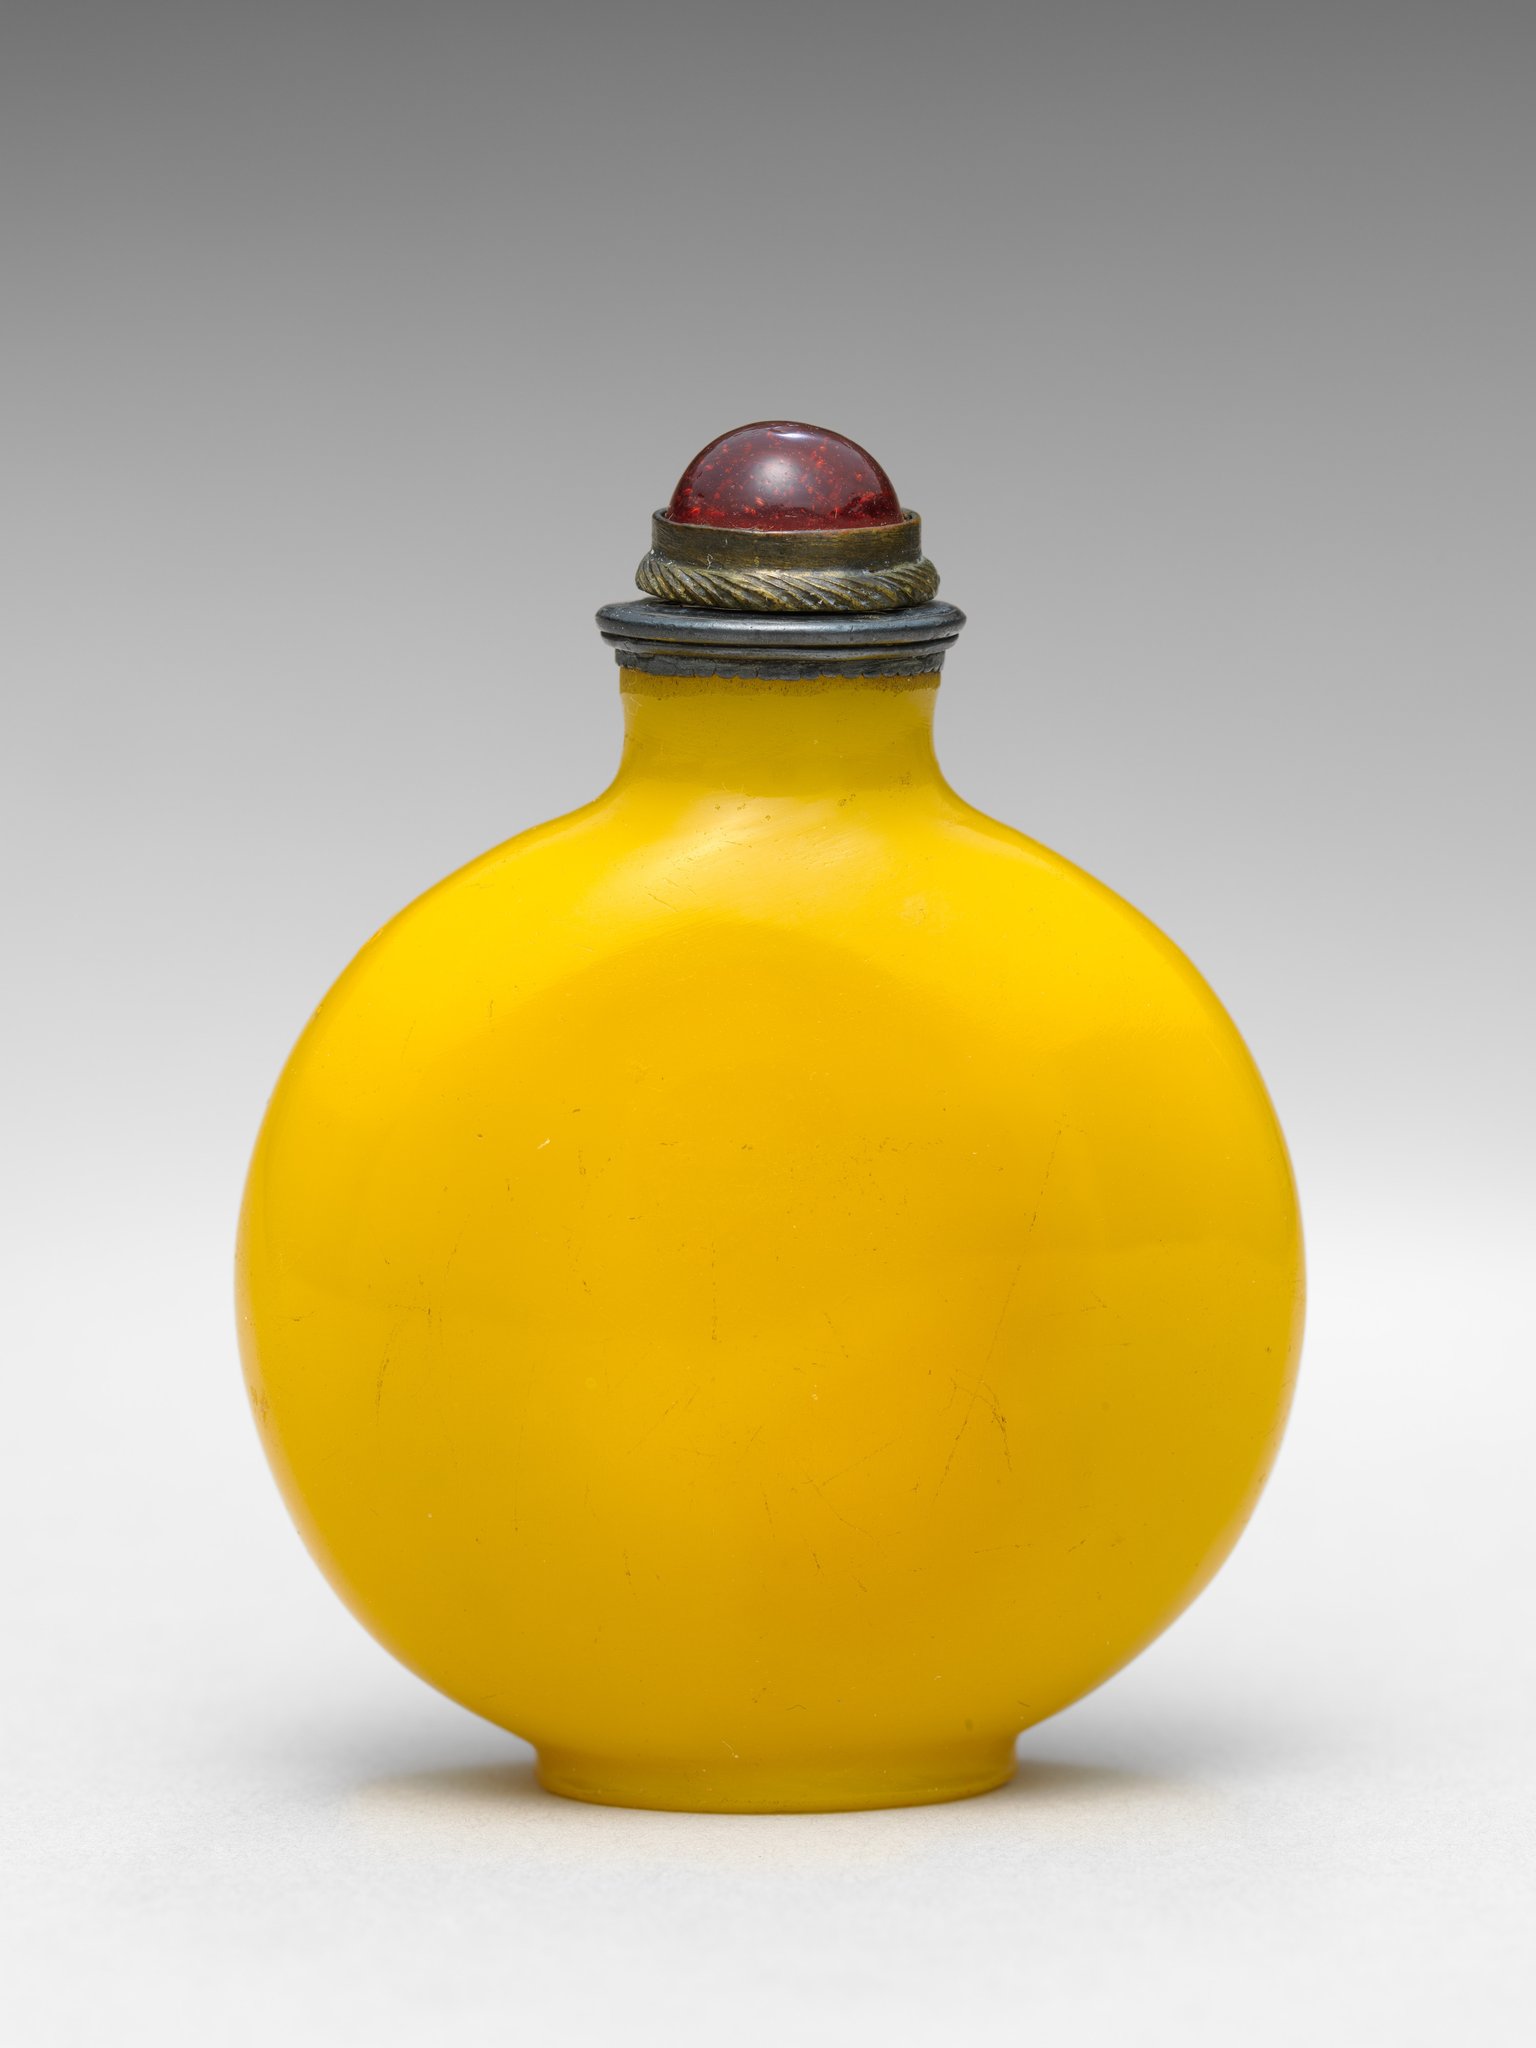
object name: snuff bottle with stopper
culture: chinese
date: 1736-1795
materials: glass